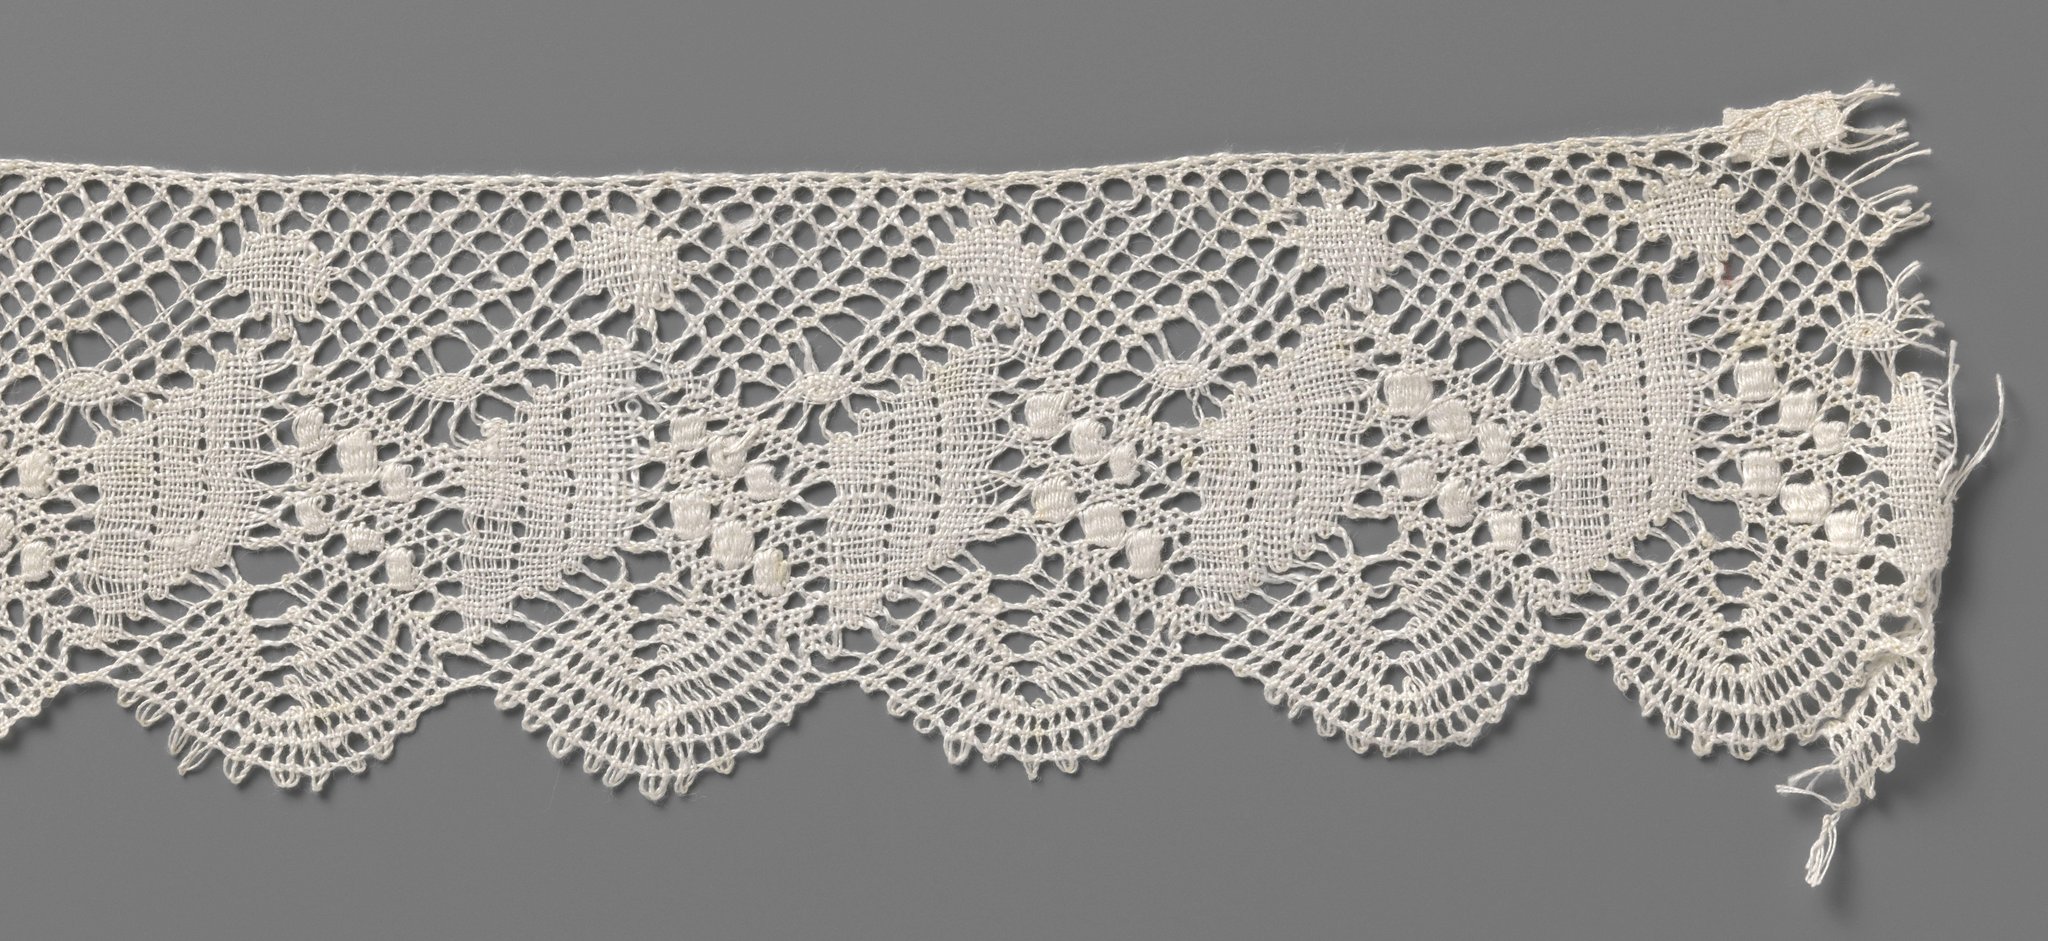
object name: strip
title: Strook kloskant met zigzag en waaierschulpen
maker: Anonymous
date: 1910-1930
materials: linen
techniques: lace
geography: netherlands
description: Strook naturelkleurige kloskant, stropkant. Symmetrische en in grove draad uitgevoerd. Korte en brede zigzaggen, half mat en half geblokt, worden naar butien toe met waaierschulpen opgevuld en aar de binnenkant met een maliënfond, waarop spinnen en blokjes staan.